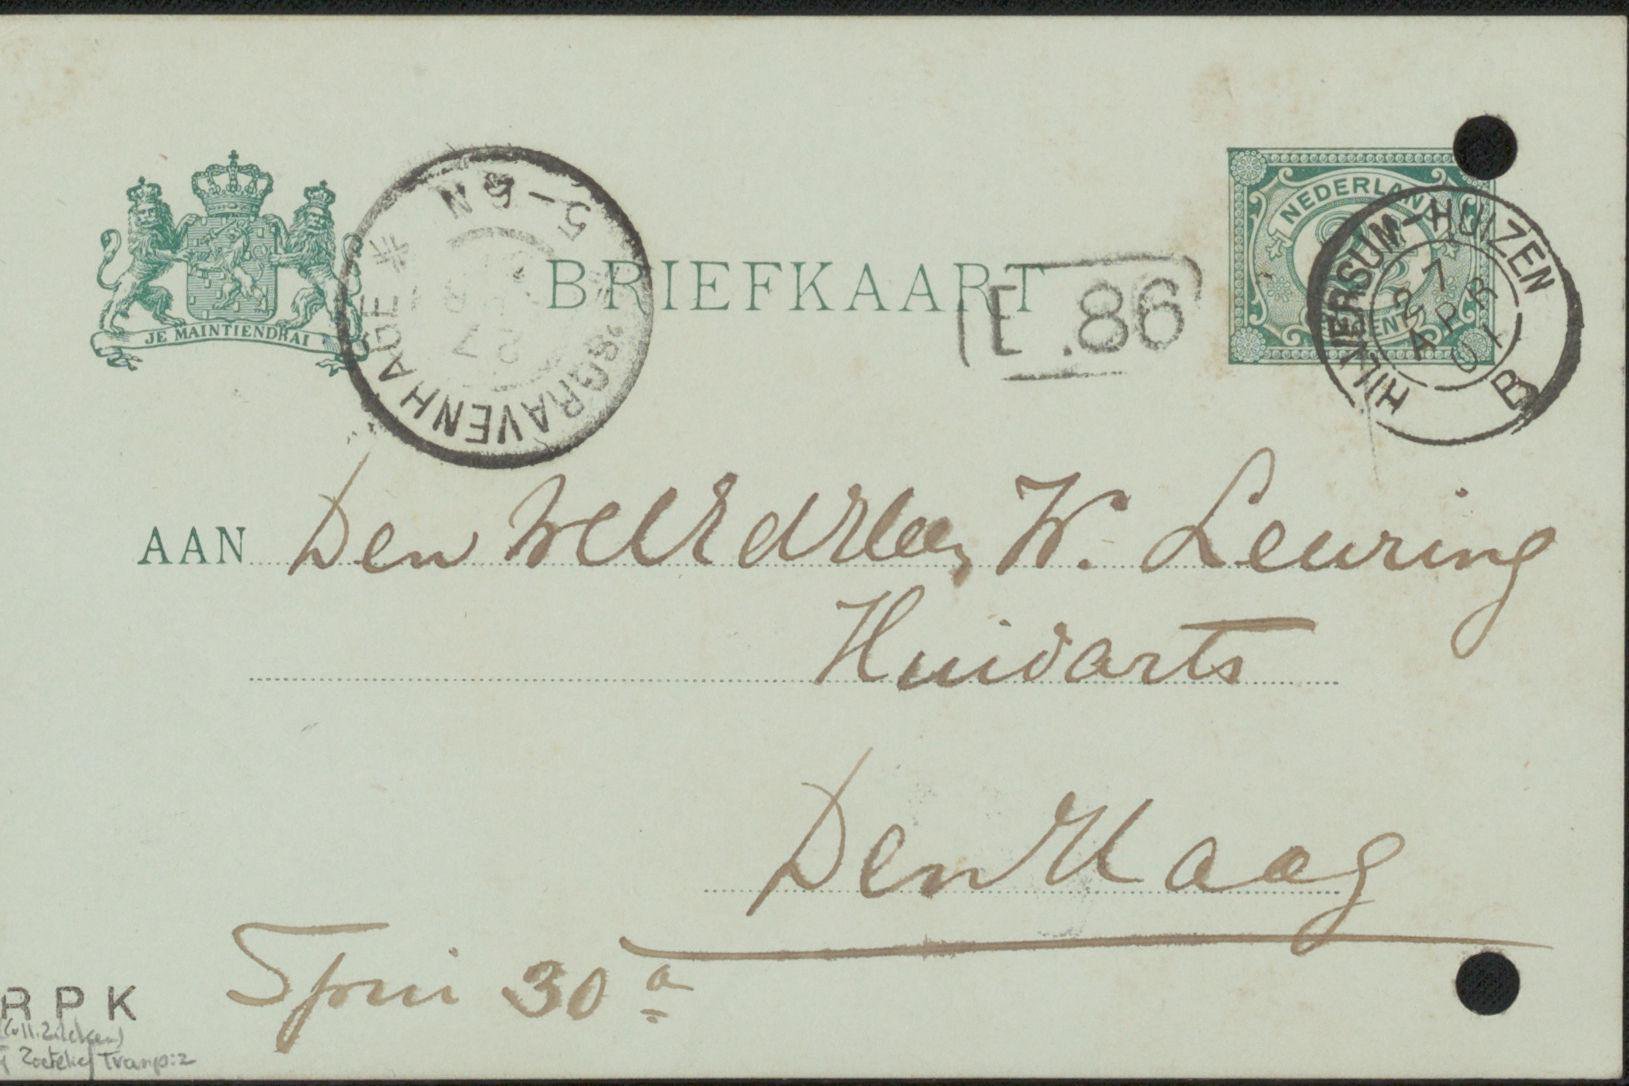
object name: postcard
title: Briefkaart aan Willem Leuring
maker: jan zoetelief tromp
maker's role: draughtsman, painter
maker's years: 1872-1947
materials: cardboard, ink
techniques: pen, writing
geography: blaricum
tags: willem leuring, painting (including book-illumination, miniature-painting), exhibition ~ art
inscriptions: collector's mark: ‘RPK’